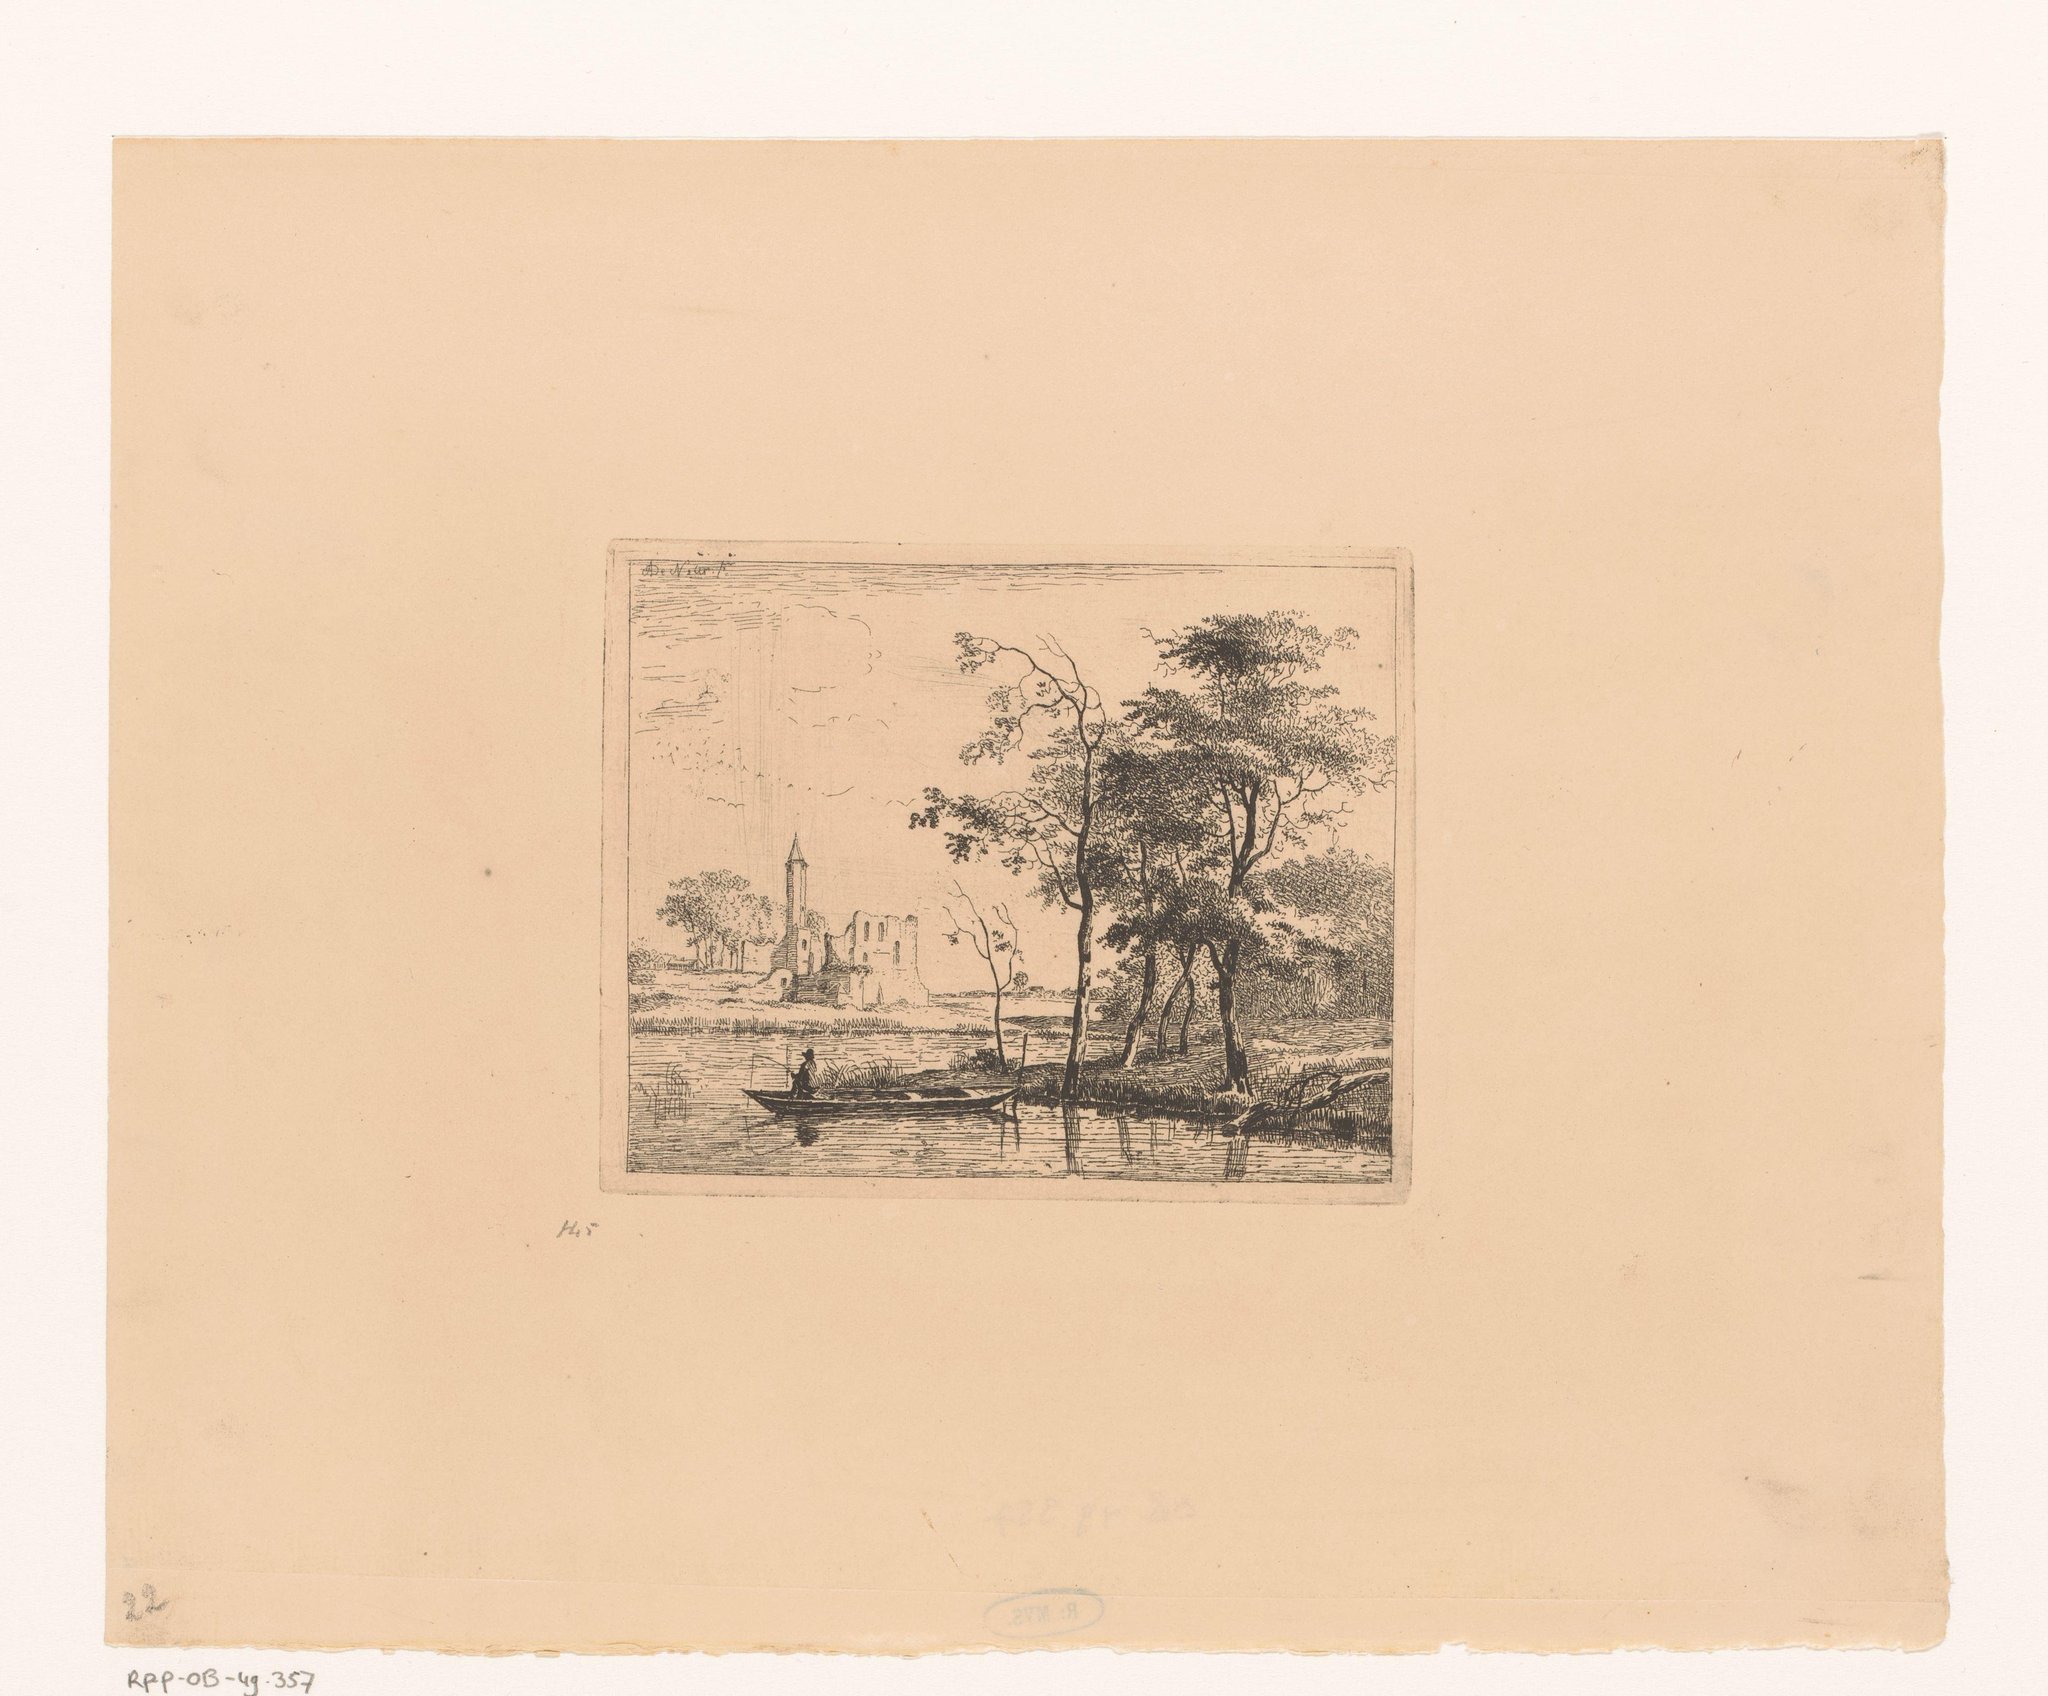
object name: print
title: Landschap met visser en kasteelruïne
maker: auguste herman marie de noter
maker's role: print maker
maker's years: 1806-1838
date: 1816-1837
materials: paper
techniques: etching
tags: landscape with ruins, fishing (sports), ruin of a dwelling, house, castle, etc.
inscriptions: collector's mark: Lugt 2228